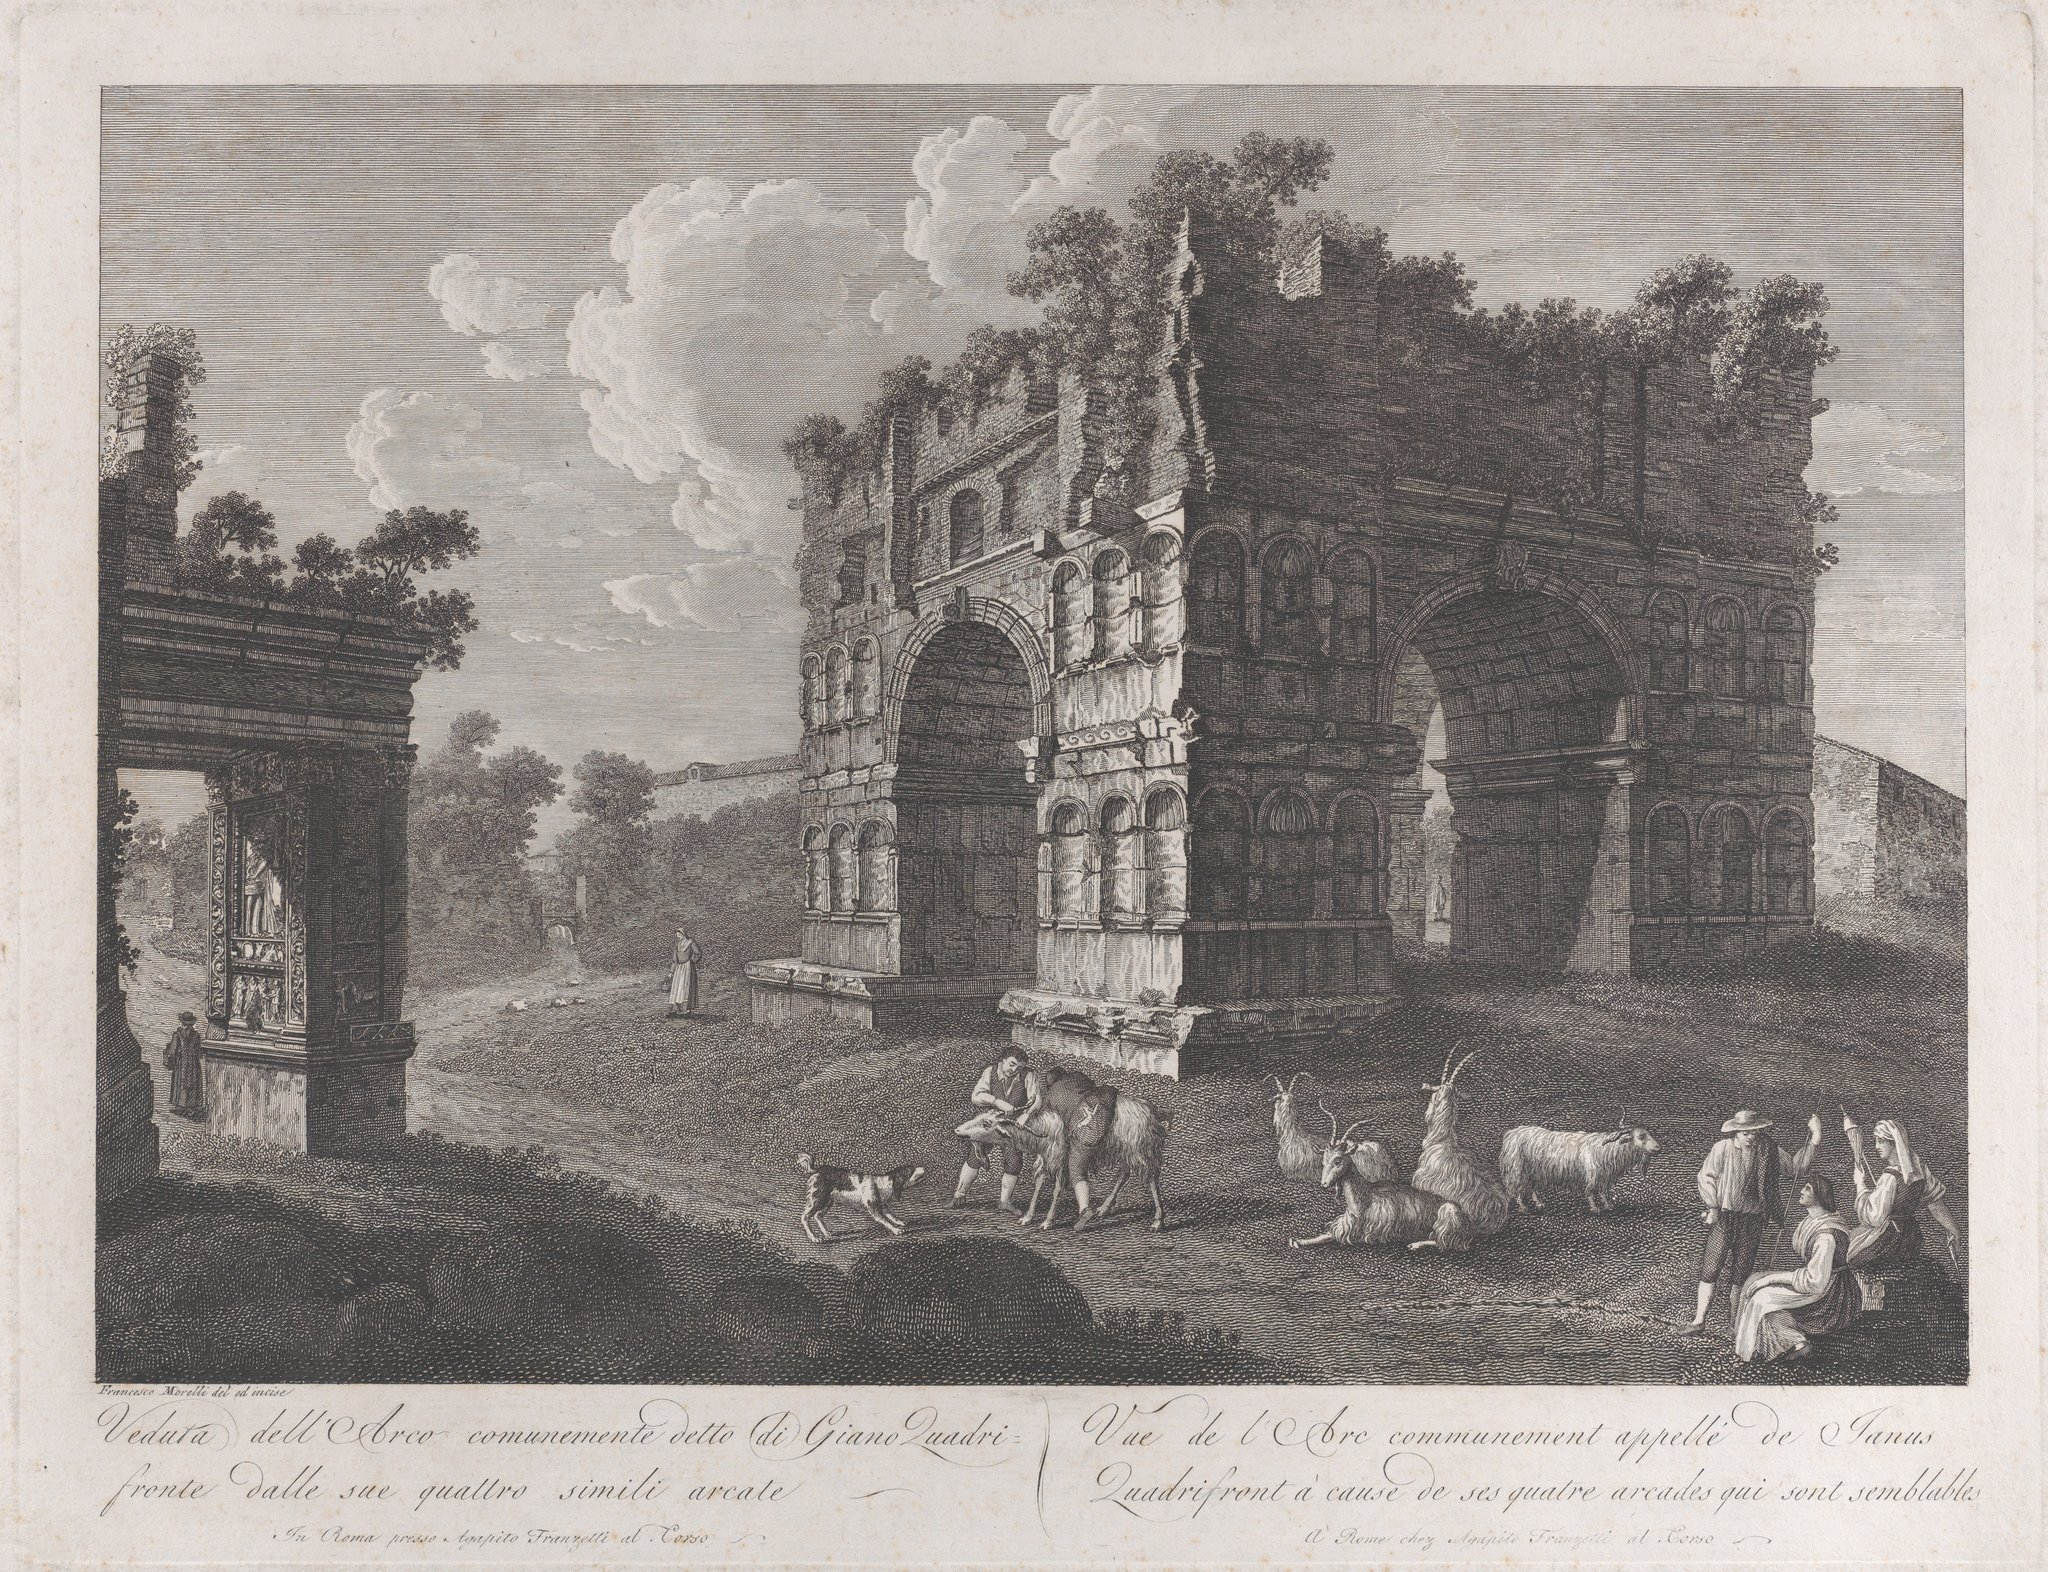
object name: print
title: View of the Arch of Janus, with shepherds and goats in the foreground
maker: françois morel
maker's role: artist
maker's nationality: french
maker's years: 1768-1830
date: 1795-1800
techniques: etching